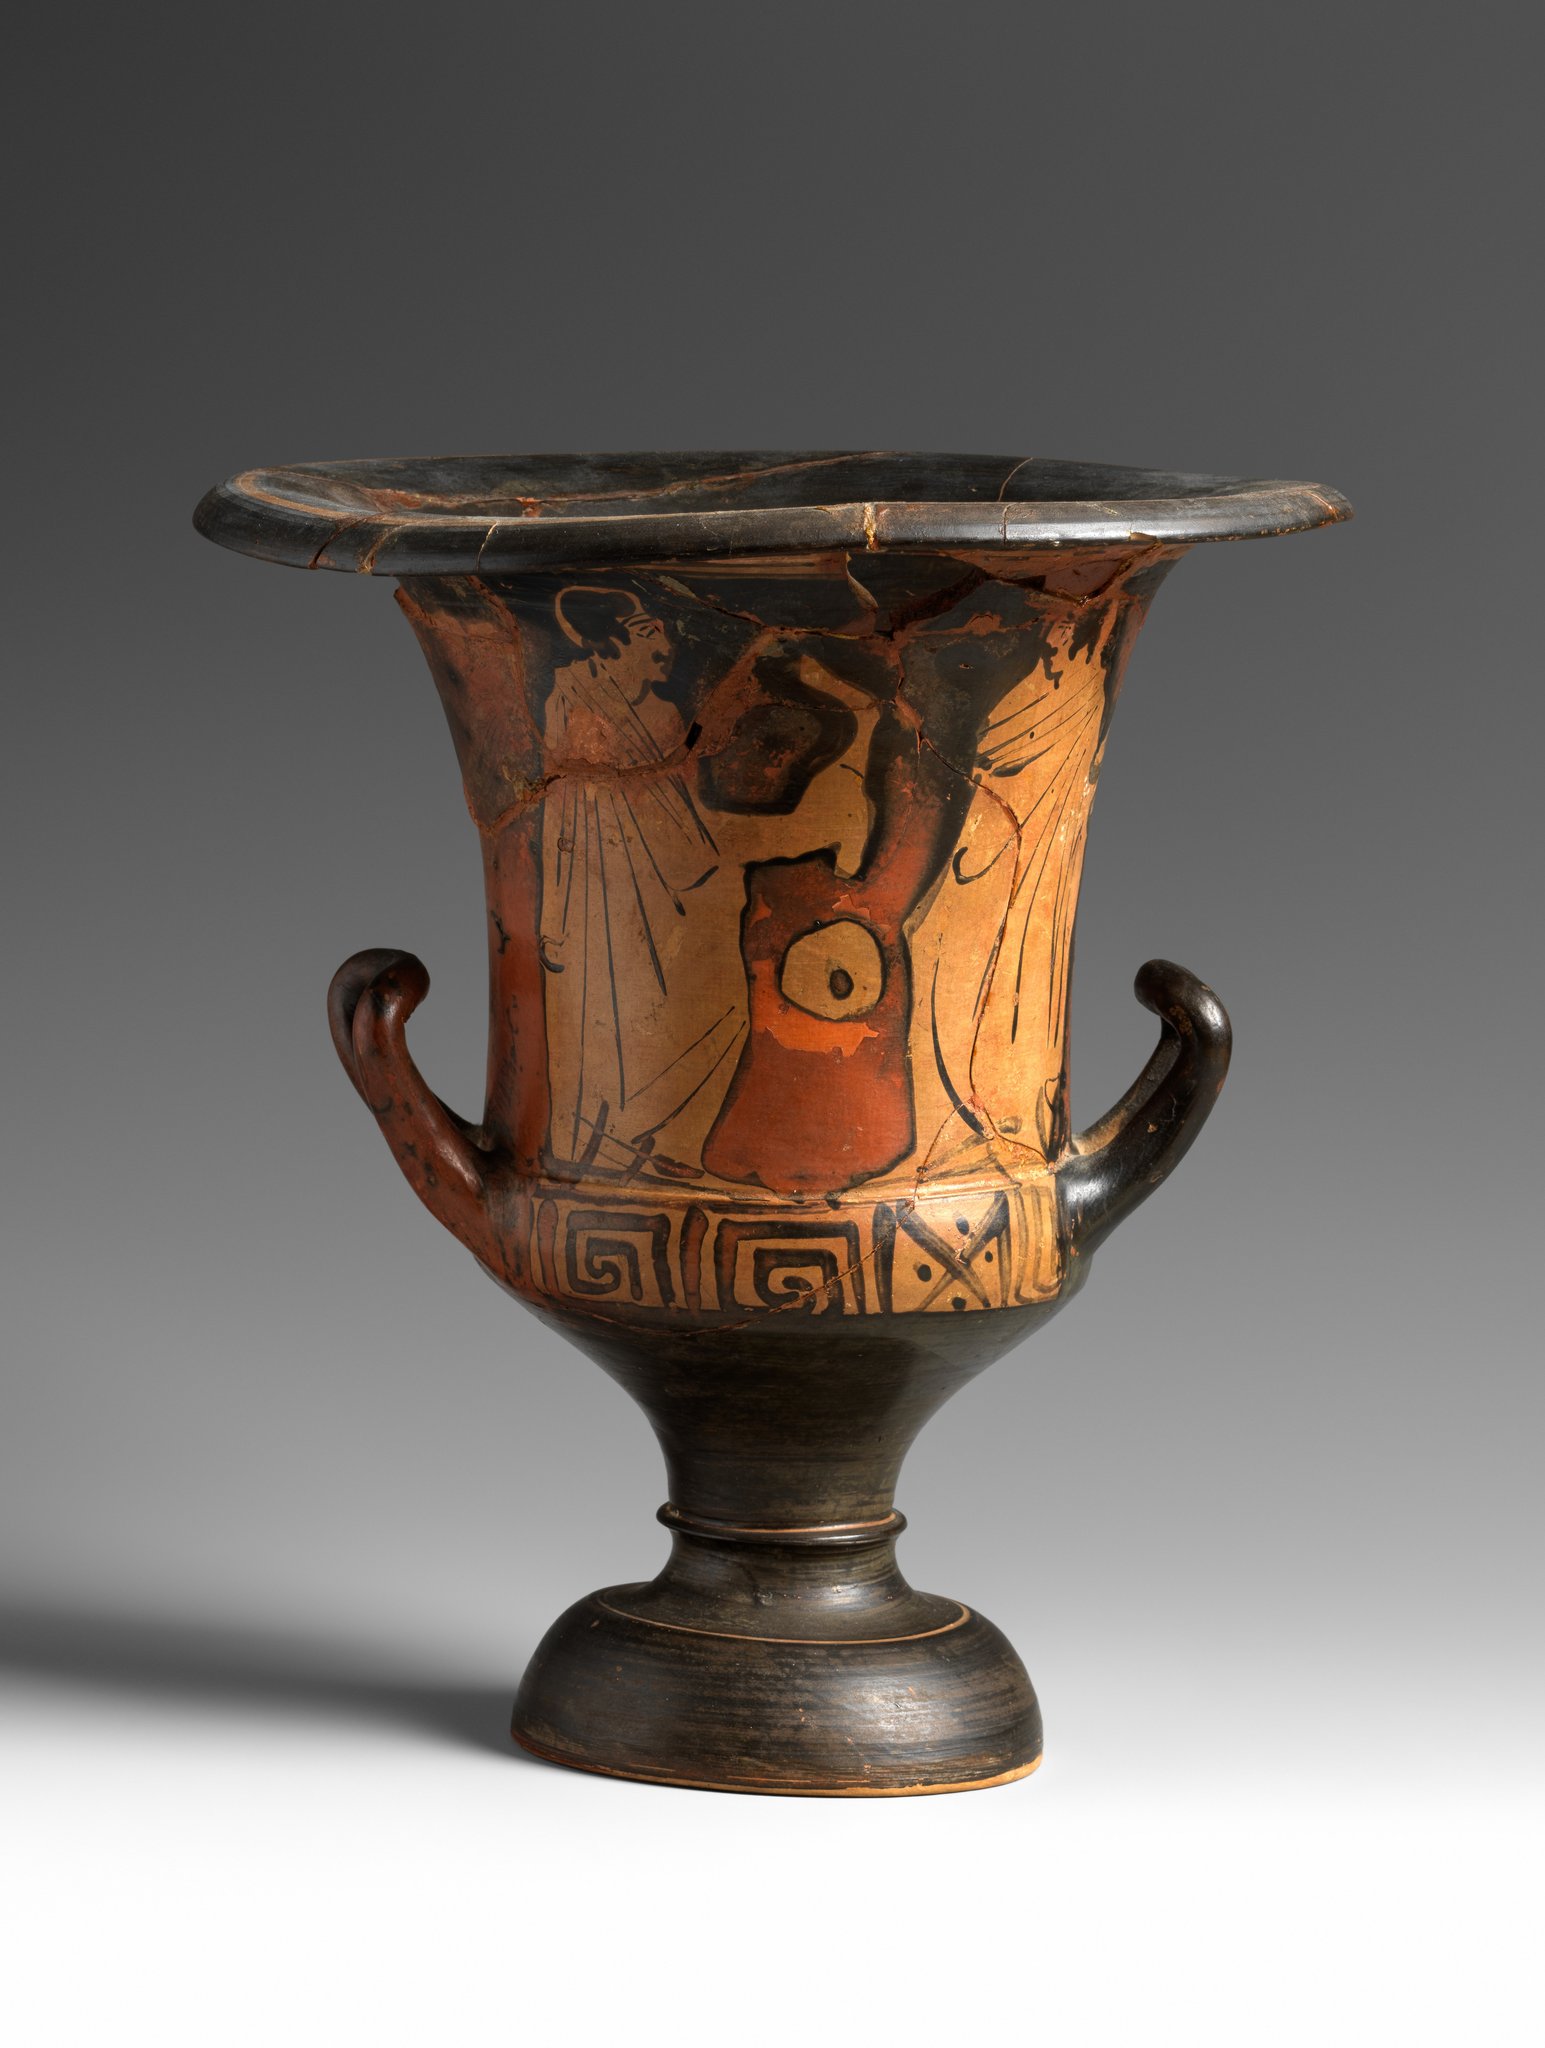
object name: calyx krater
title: Red-figure calyx-krater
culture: greek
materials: terracotta